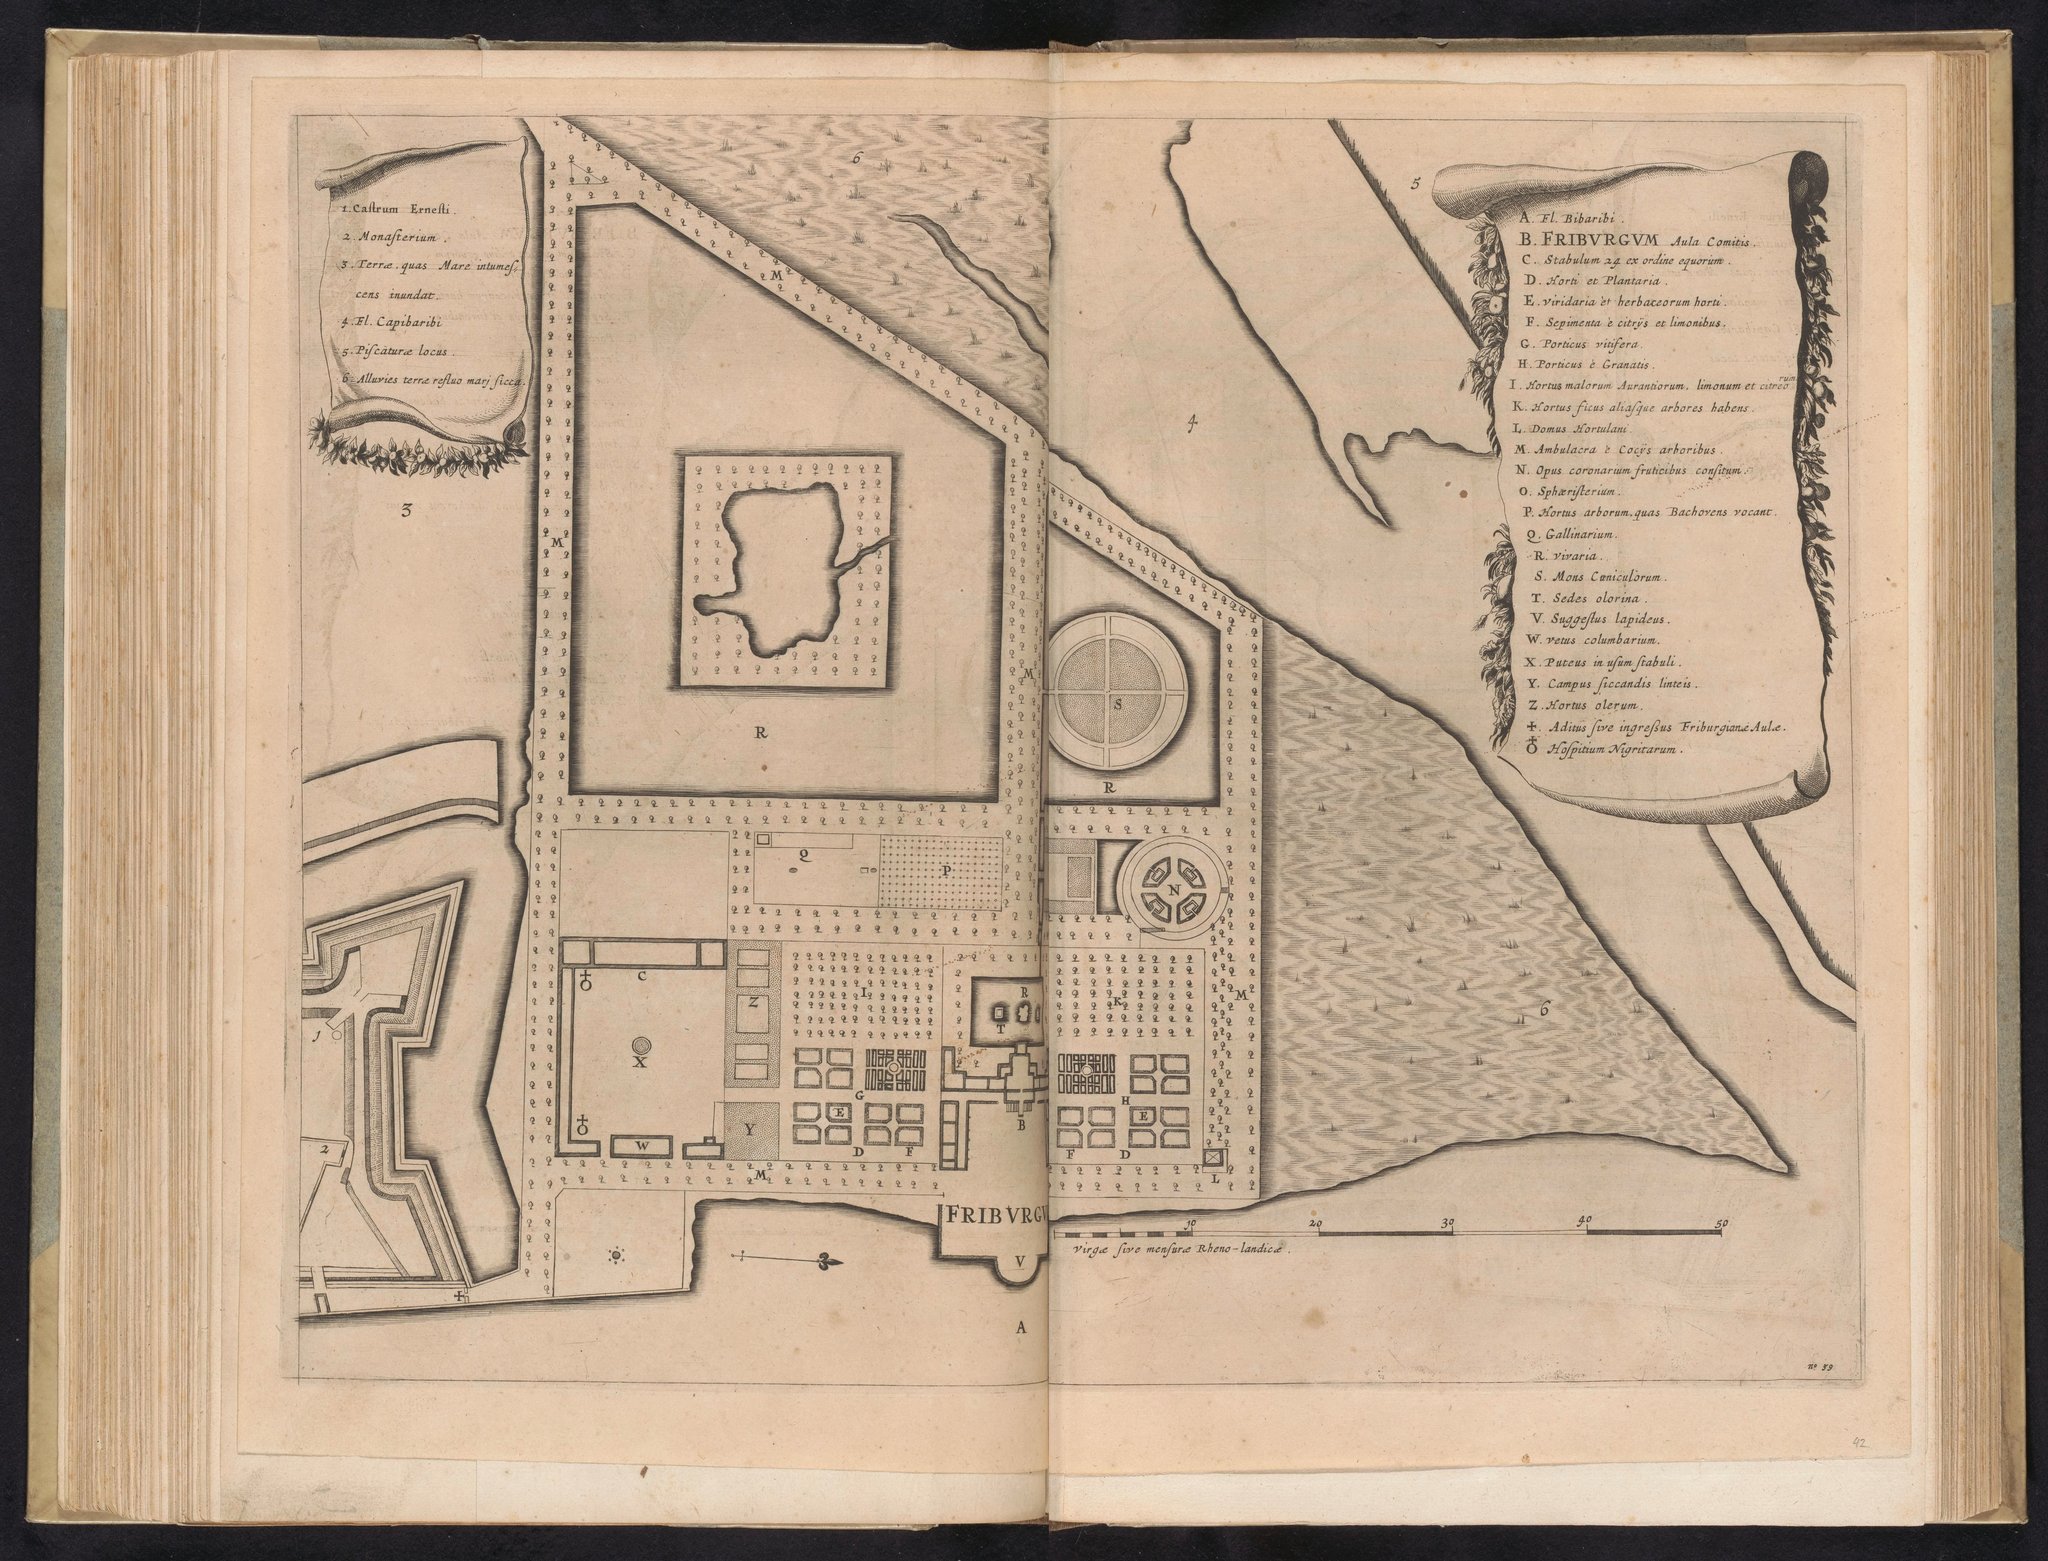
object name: map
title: Friburgum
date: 1645-1647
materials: paper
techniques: engraving, etching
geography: amsterdam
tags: earl, johan maurits graaf van nassau-siegen, maps of cities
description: Plattegrond van paleis Vrijburg in Mauritsstad, ca. 1636-1644. Rechts een banderol met de verklaring van de letters A-Z (plus twee extra tekens) in het Latijn. Plaat nr. 39 in een serie van 55 voorstellingen van de tocht naar en het verblijf in Brazilië van graaf Johan Maurits van Nassau in de jaren 1636-1644.